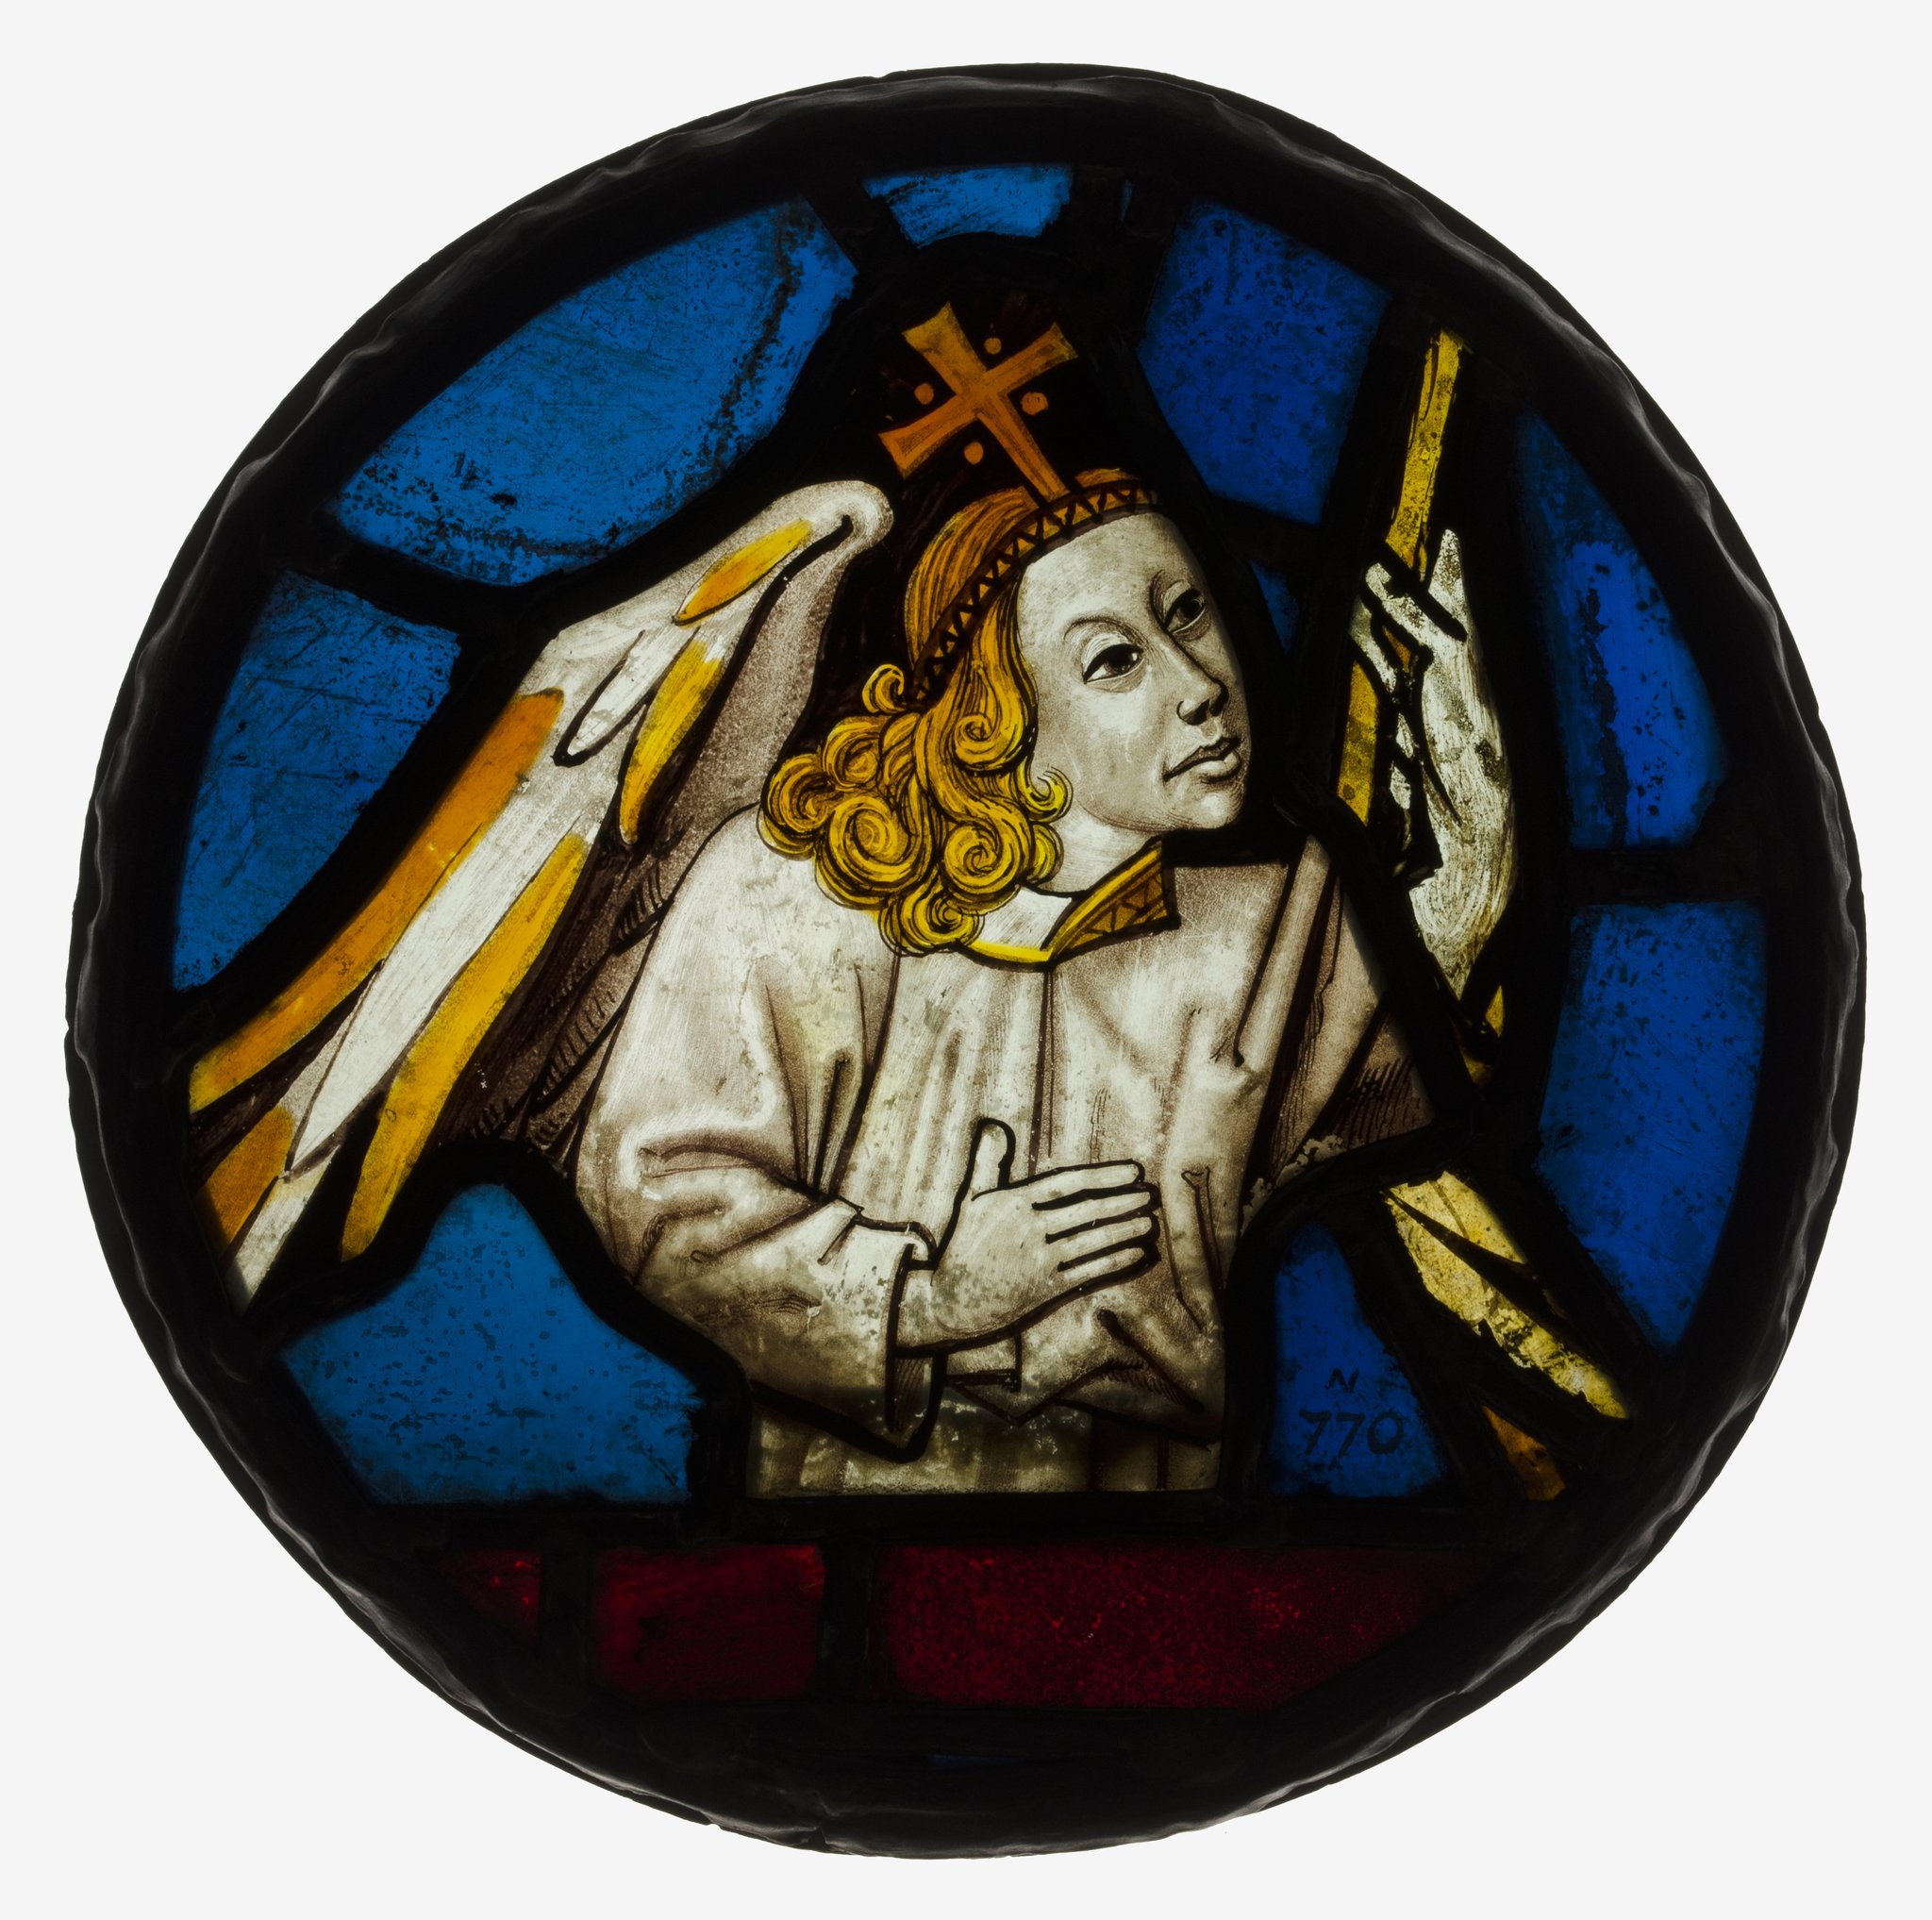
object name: roundel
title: Angel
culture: british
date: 1401-1500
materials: glass, metal, paint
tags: cross